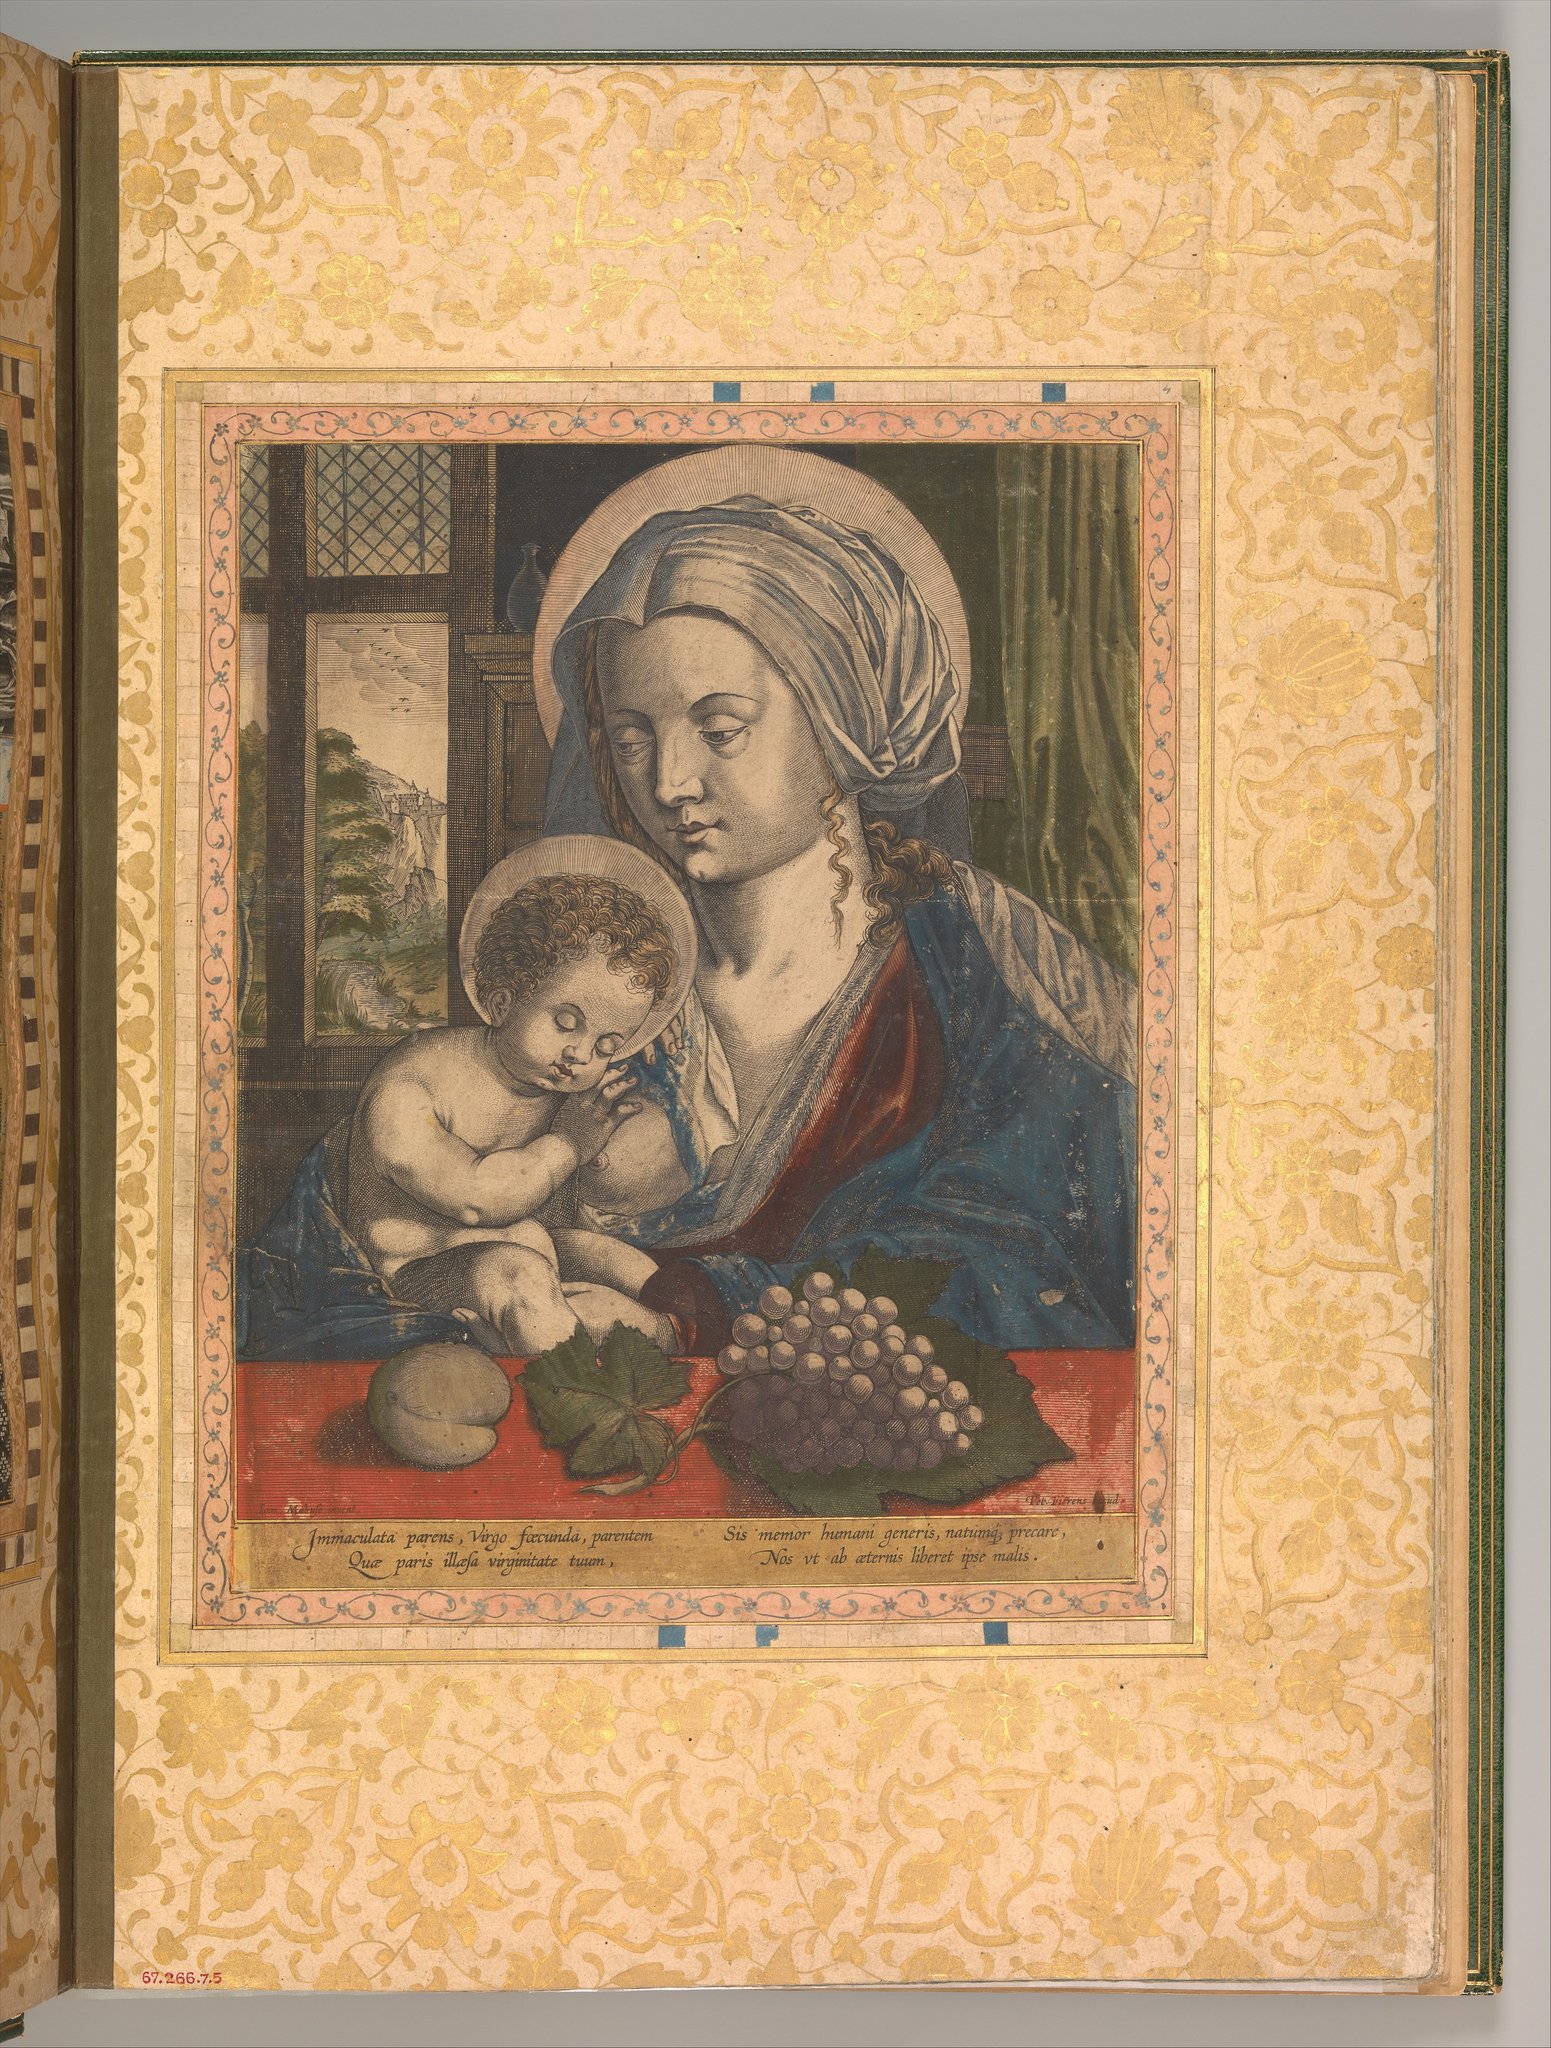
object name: illustrated album leaf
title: "Virgin and Child," Folio from the Bellini Album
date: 1600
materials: gold, ink, paper, watercolor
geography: netherlands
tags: grapes,madonna and child